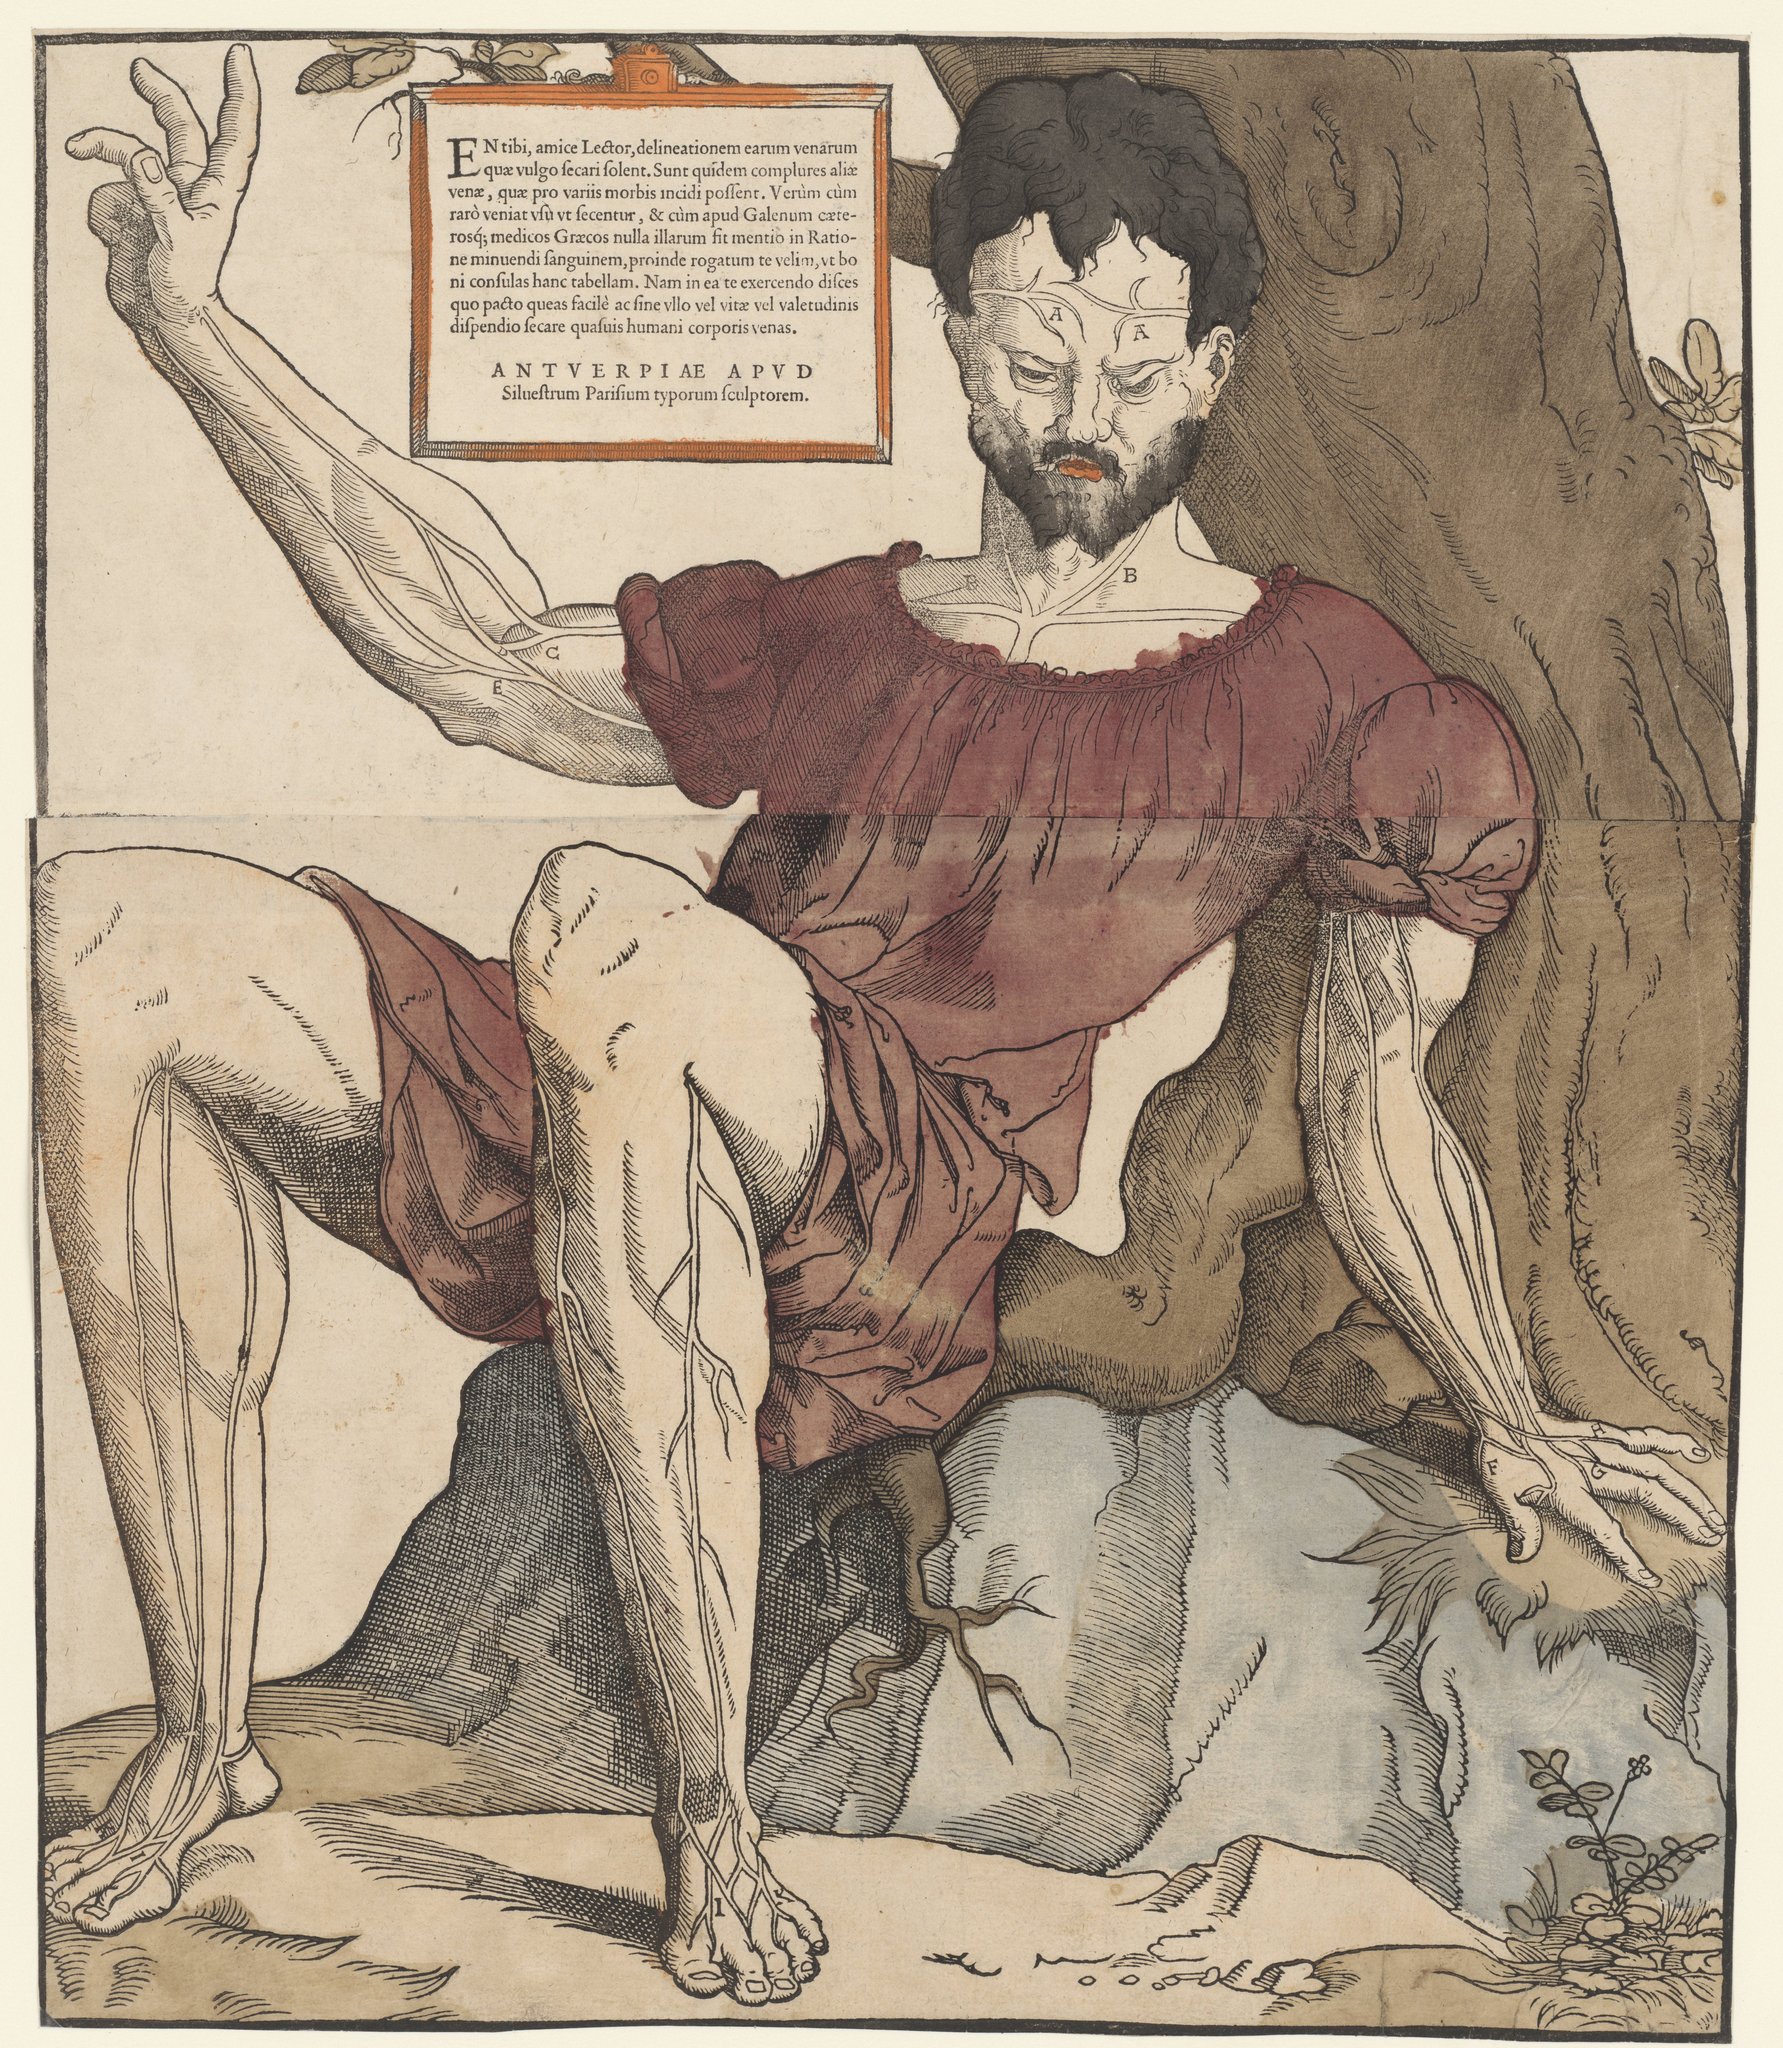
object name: print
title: De aderen van het menselijk lichaam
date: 1525-1573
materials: paper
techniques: hand coloring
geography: antwerp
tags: anatomical model of the arteries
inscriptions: address: ‘ANTVERPIAE APVD Silvestrum Parisium typorum sculptorem’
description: Gedrukt van twee blokken op twee bladen, aan elkaar bevestigd. Man zittend op steen bij voet van boom, aderen op zijn lichaam zichtbaar, verschillende aderen met letters aangegeven. In cartouche tekst in Latijn.